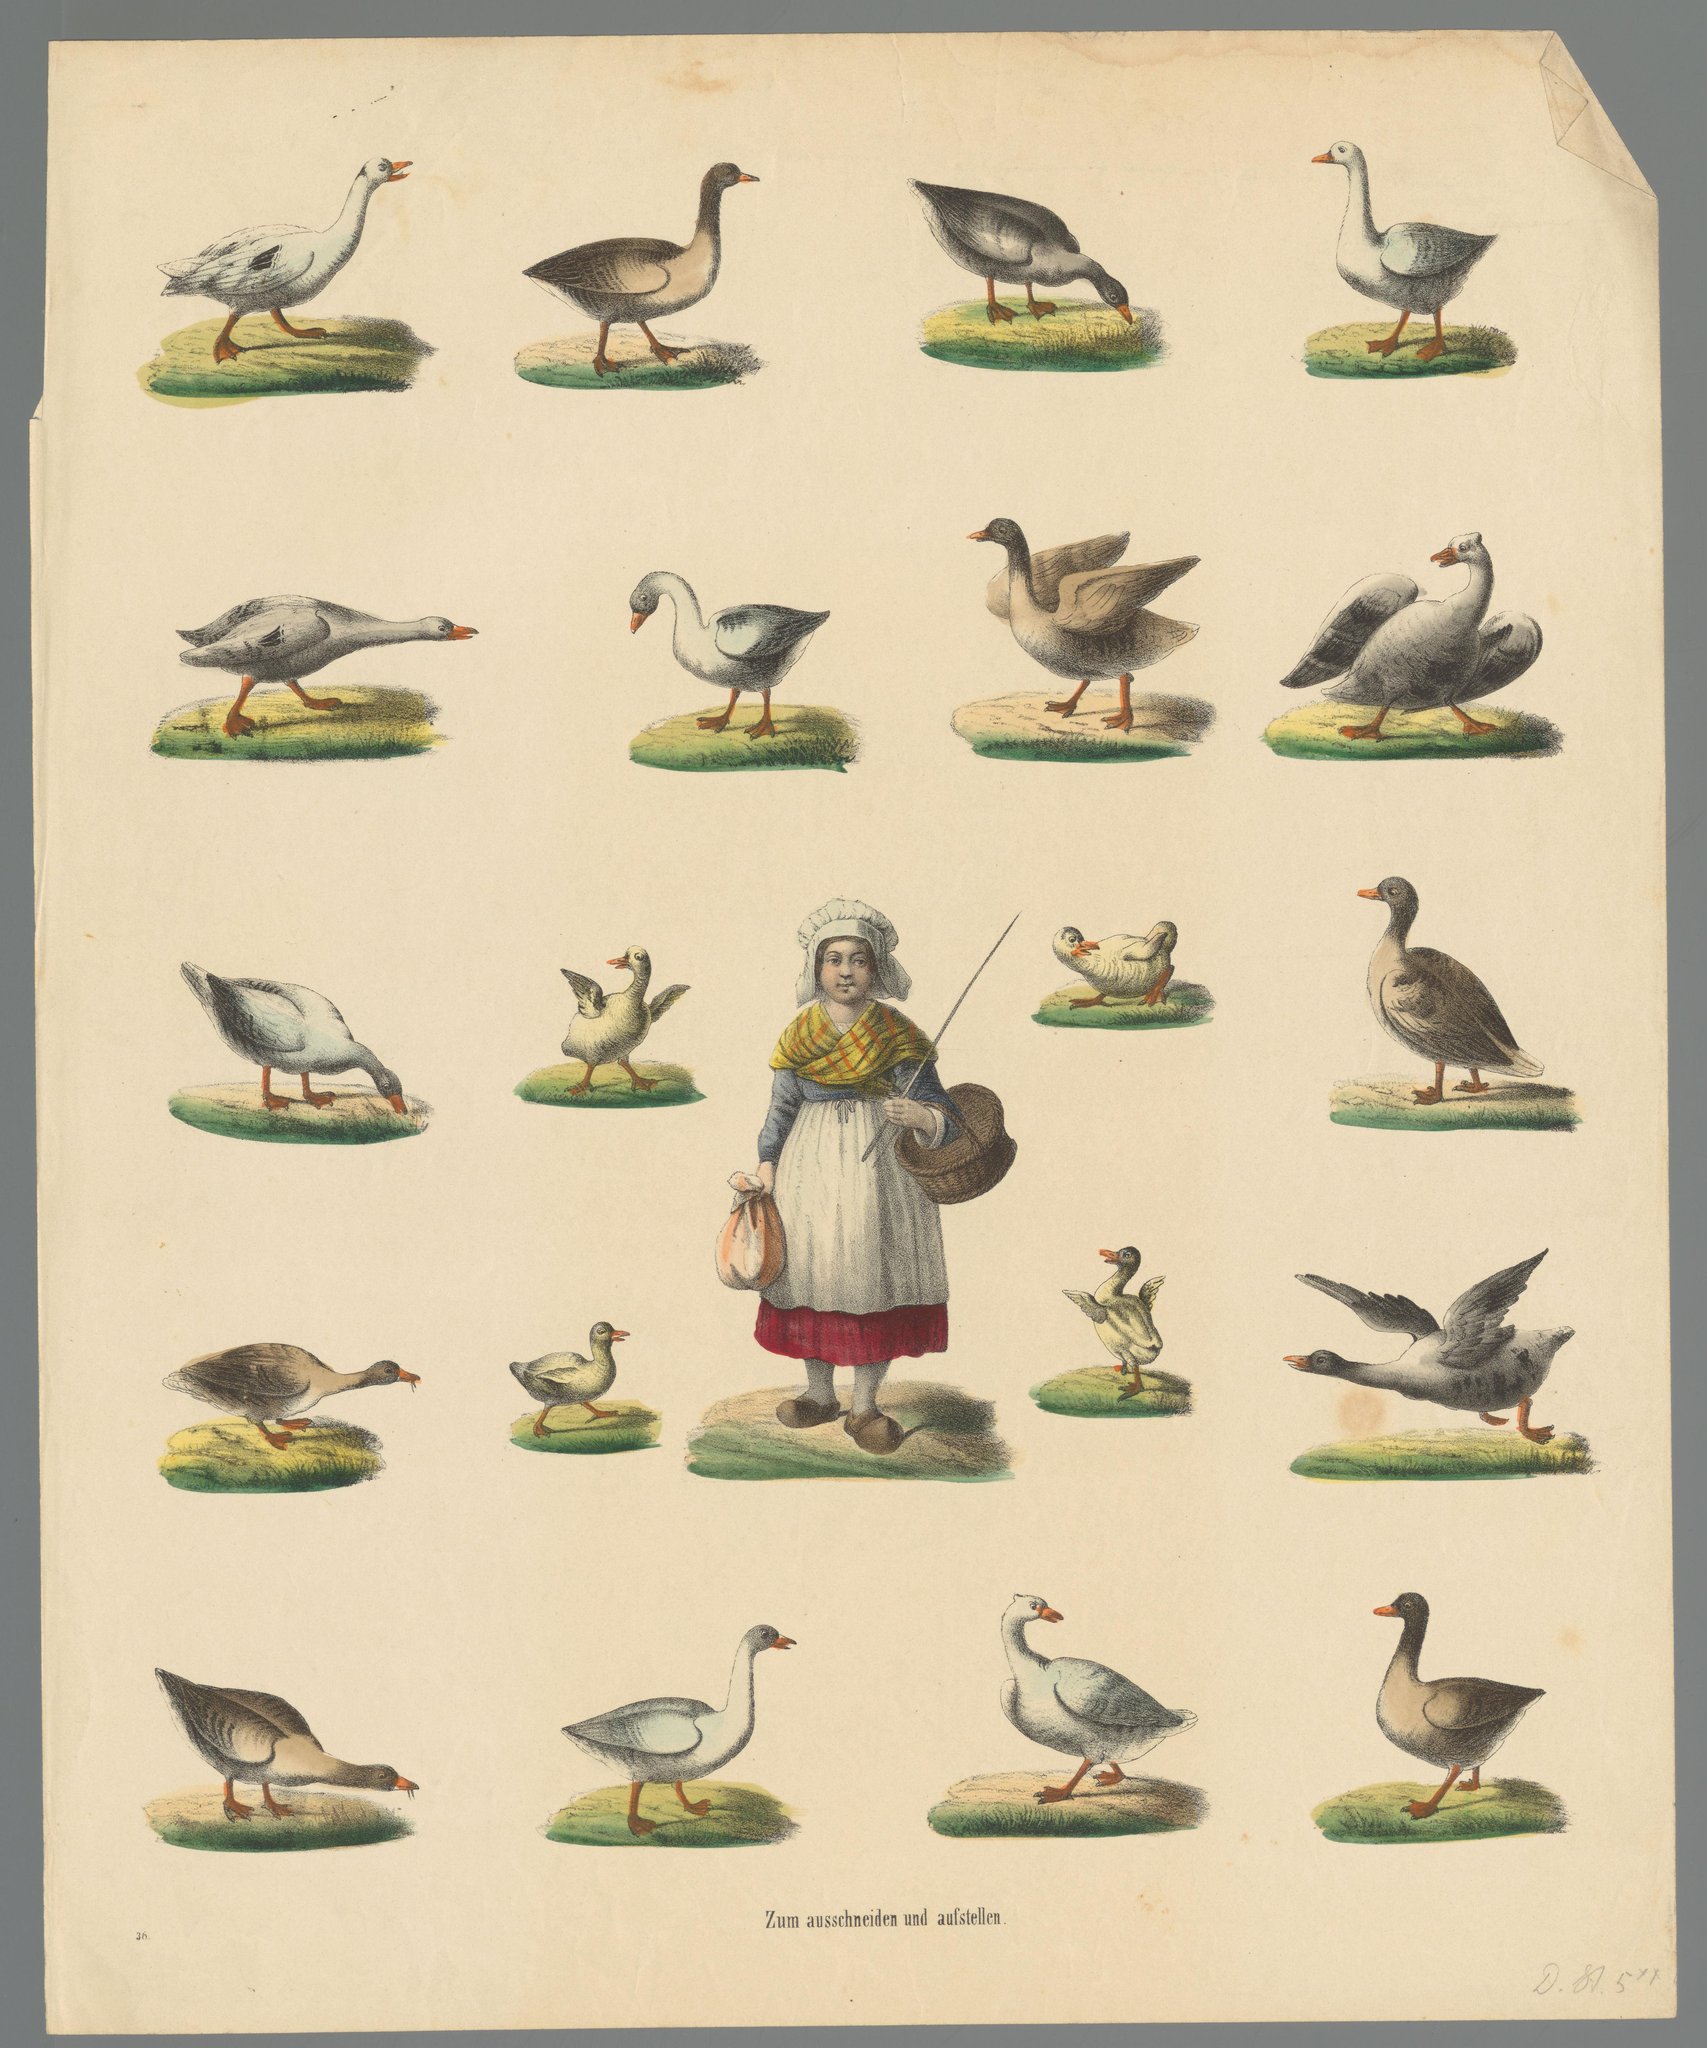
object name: print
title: Meisje met eenden en ganzen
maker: Anonymous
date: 1840-1921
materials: paper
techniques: hand coloring, lithograph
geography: germany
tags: water-birds: goose, girl (child between toddler and youth), water-birds: duck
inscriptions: collector's mark: Lugt 2233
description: De figuren op de prent konden los worden uitgeknipt.